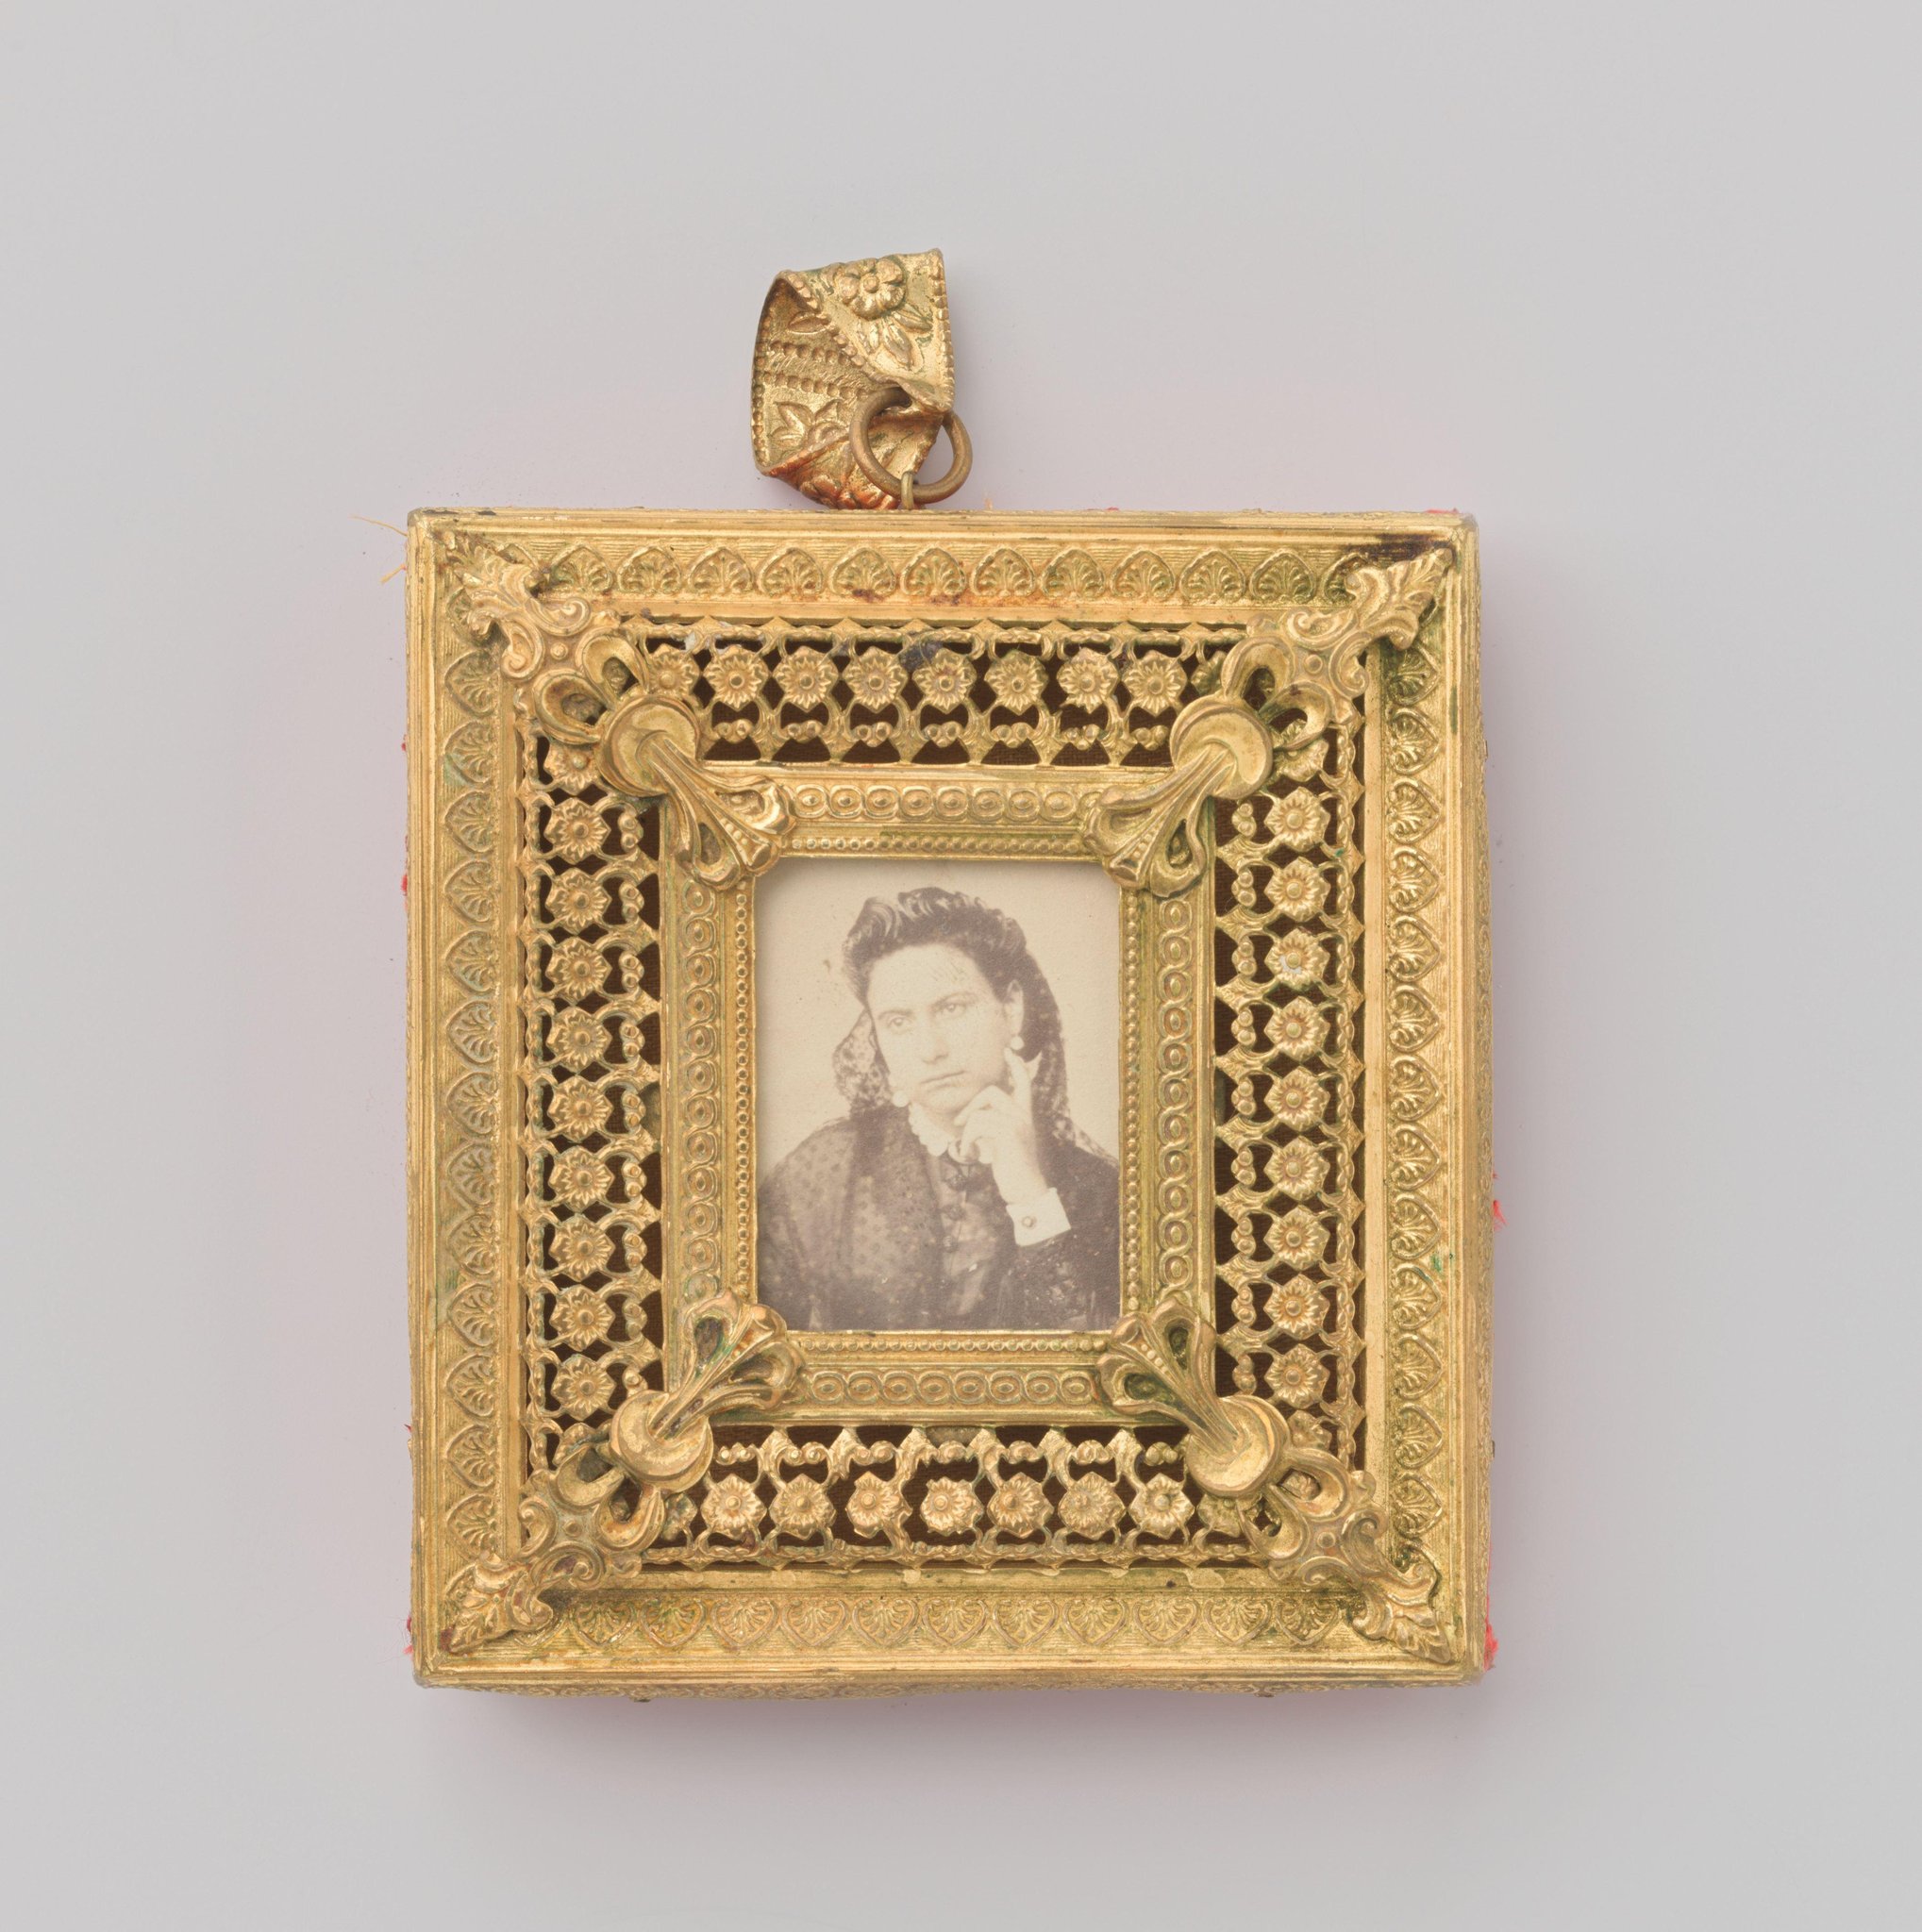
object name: photograph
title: Portret van een onbekende jonge vrouw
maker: Anonymous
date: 1880-1900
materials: cardboard, glass, metal, paper, textile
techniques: albumen print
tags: adult woman, anonymous historical person portrayed